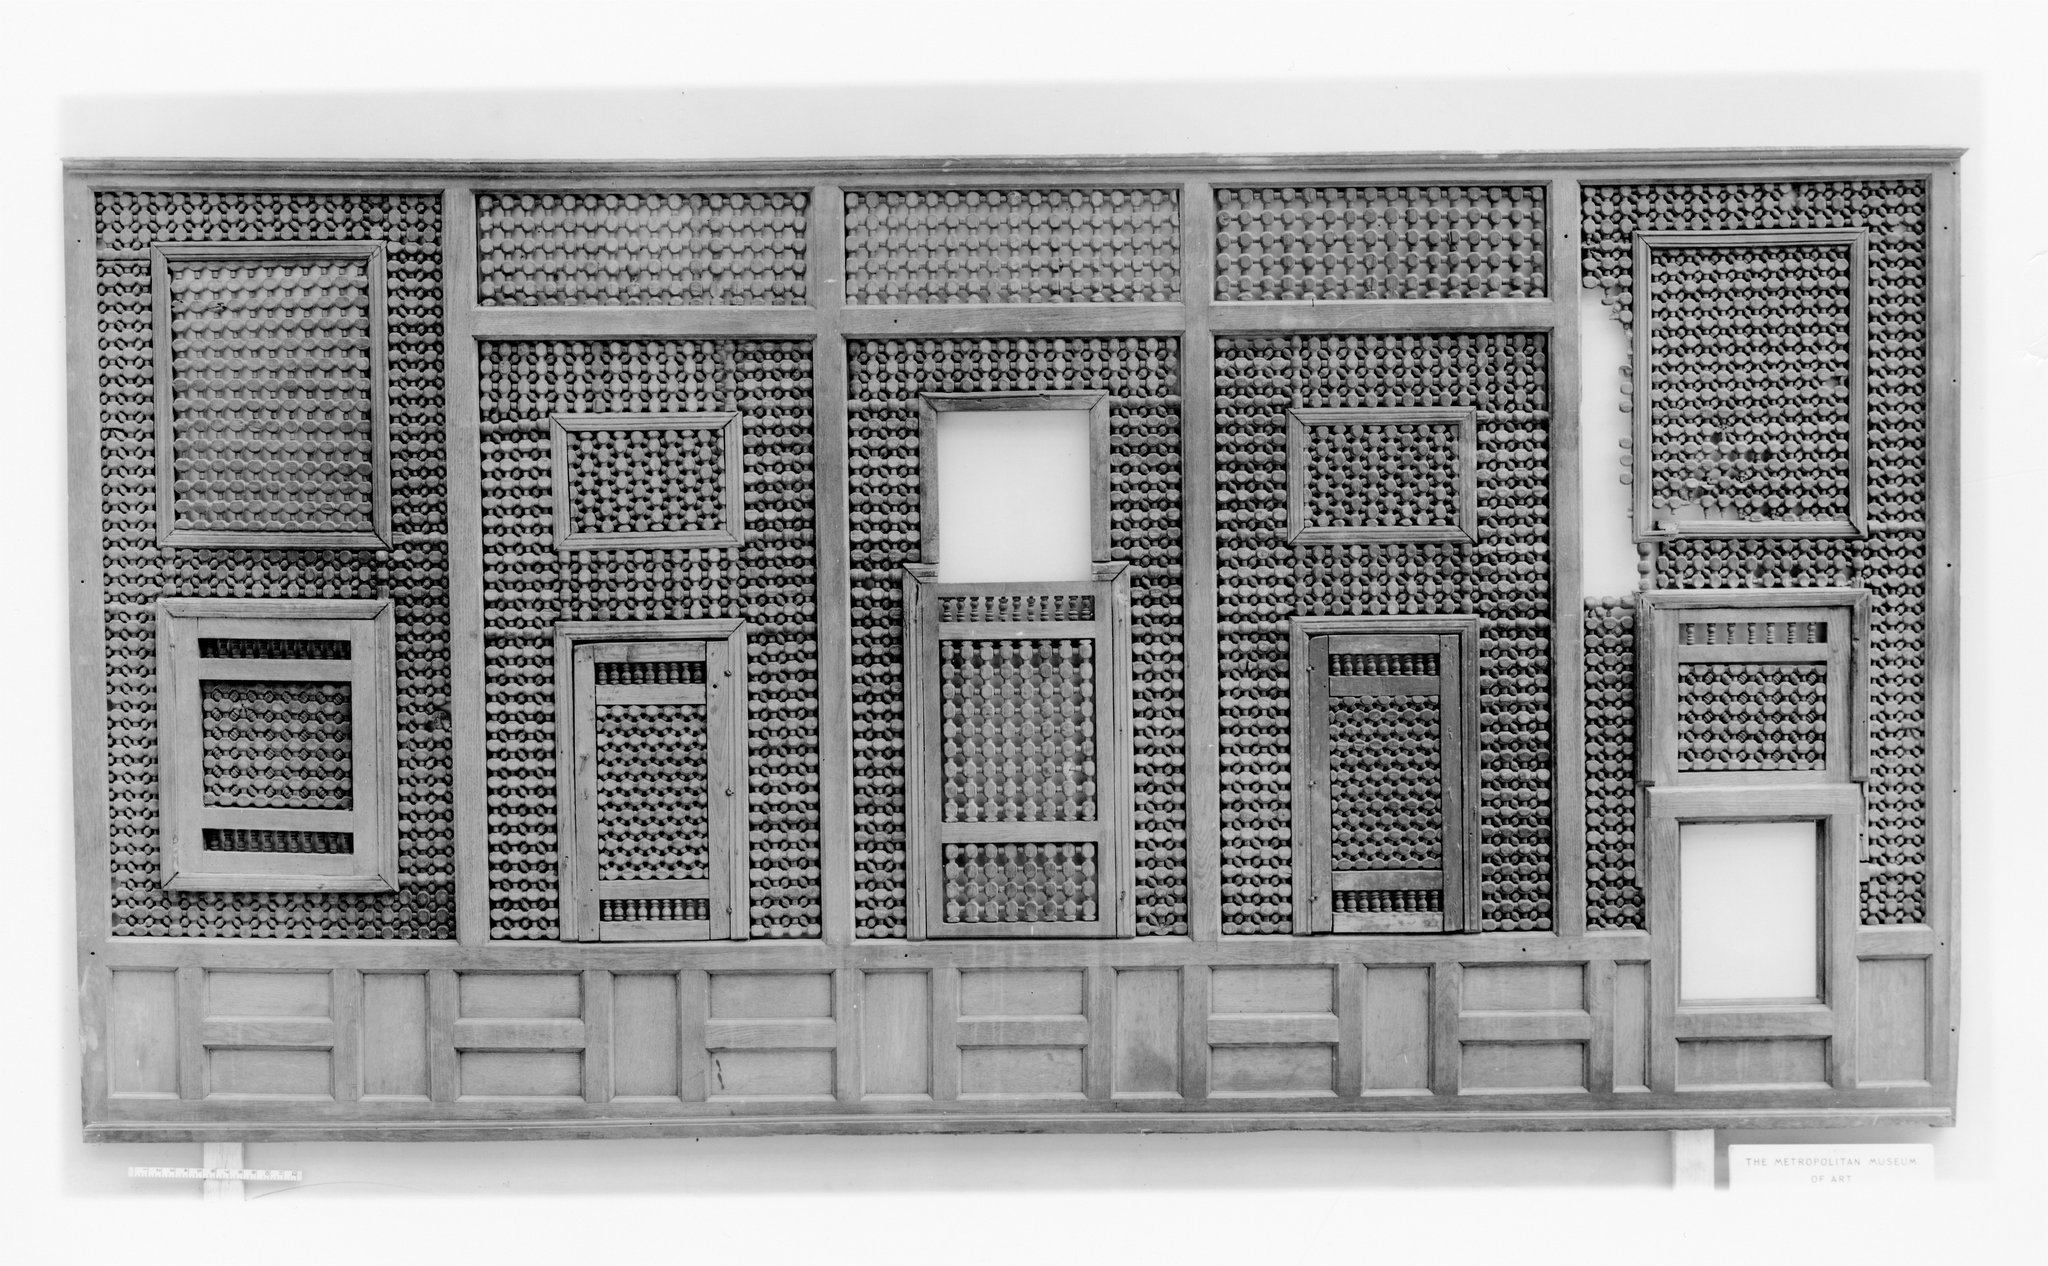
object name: screen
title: Mashrabiyya Screen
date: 1401-1600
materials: wood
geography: egypt